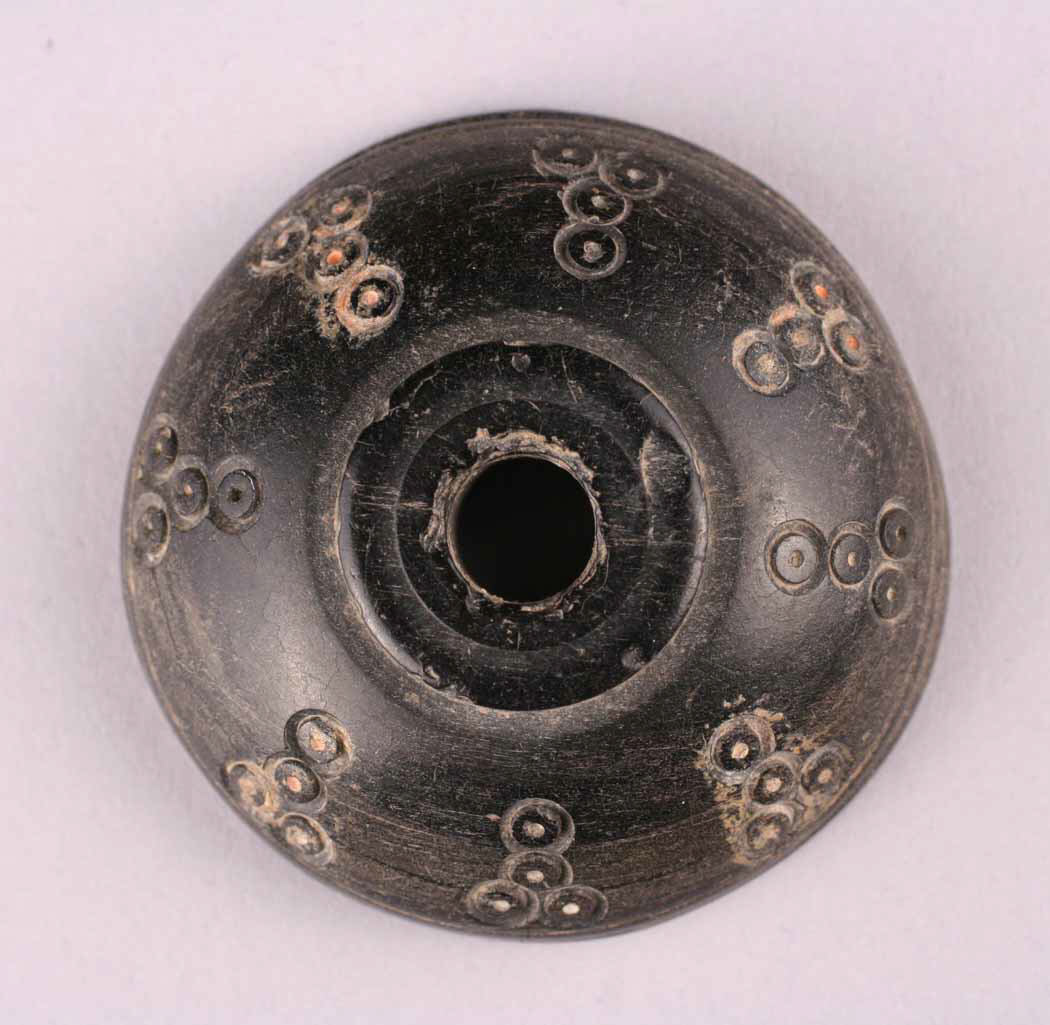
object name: button or bead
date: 701-1000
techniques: incising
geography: iran